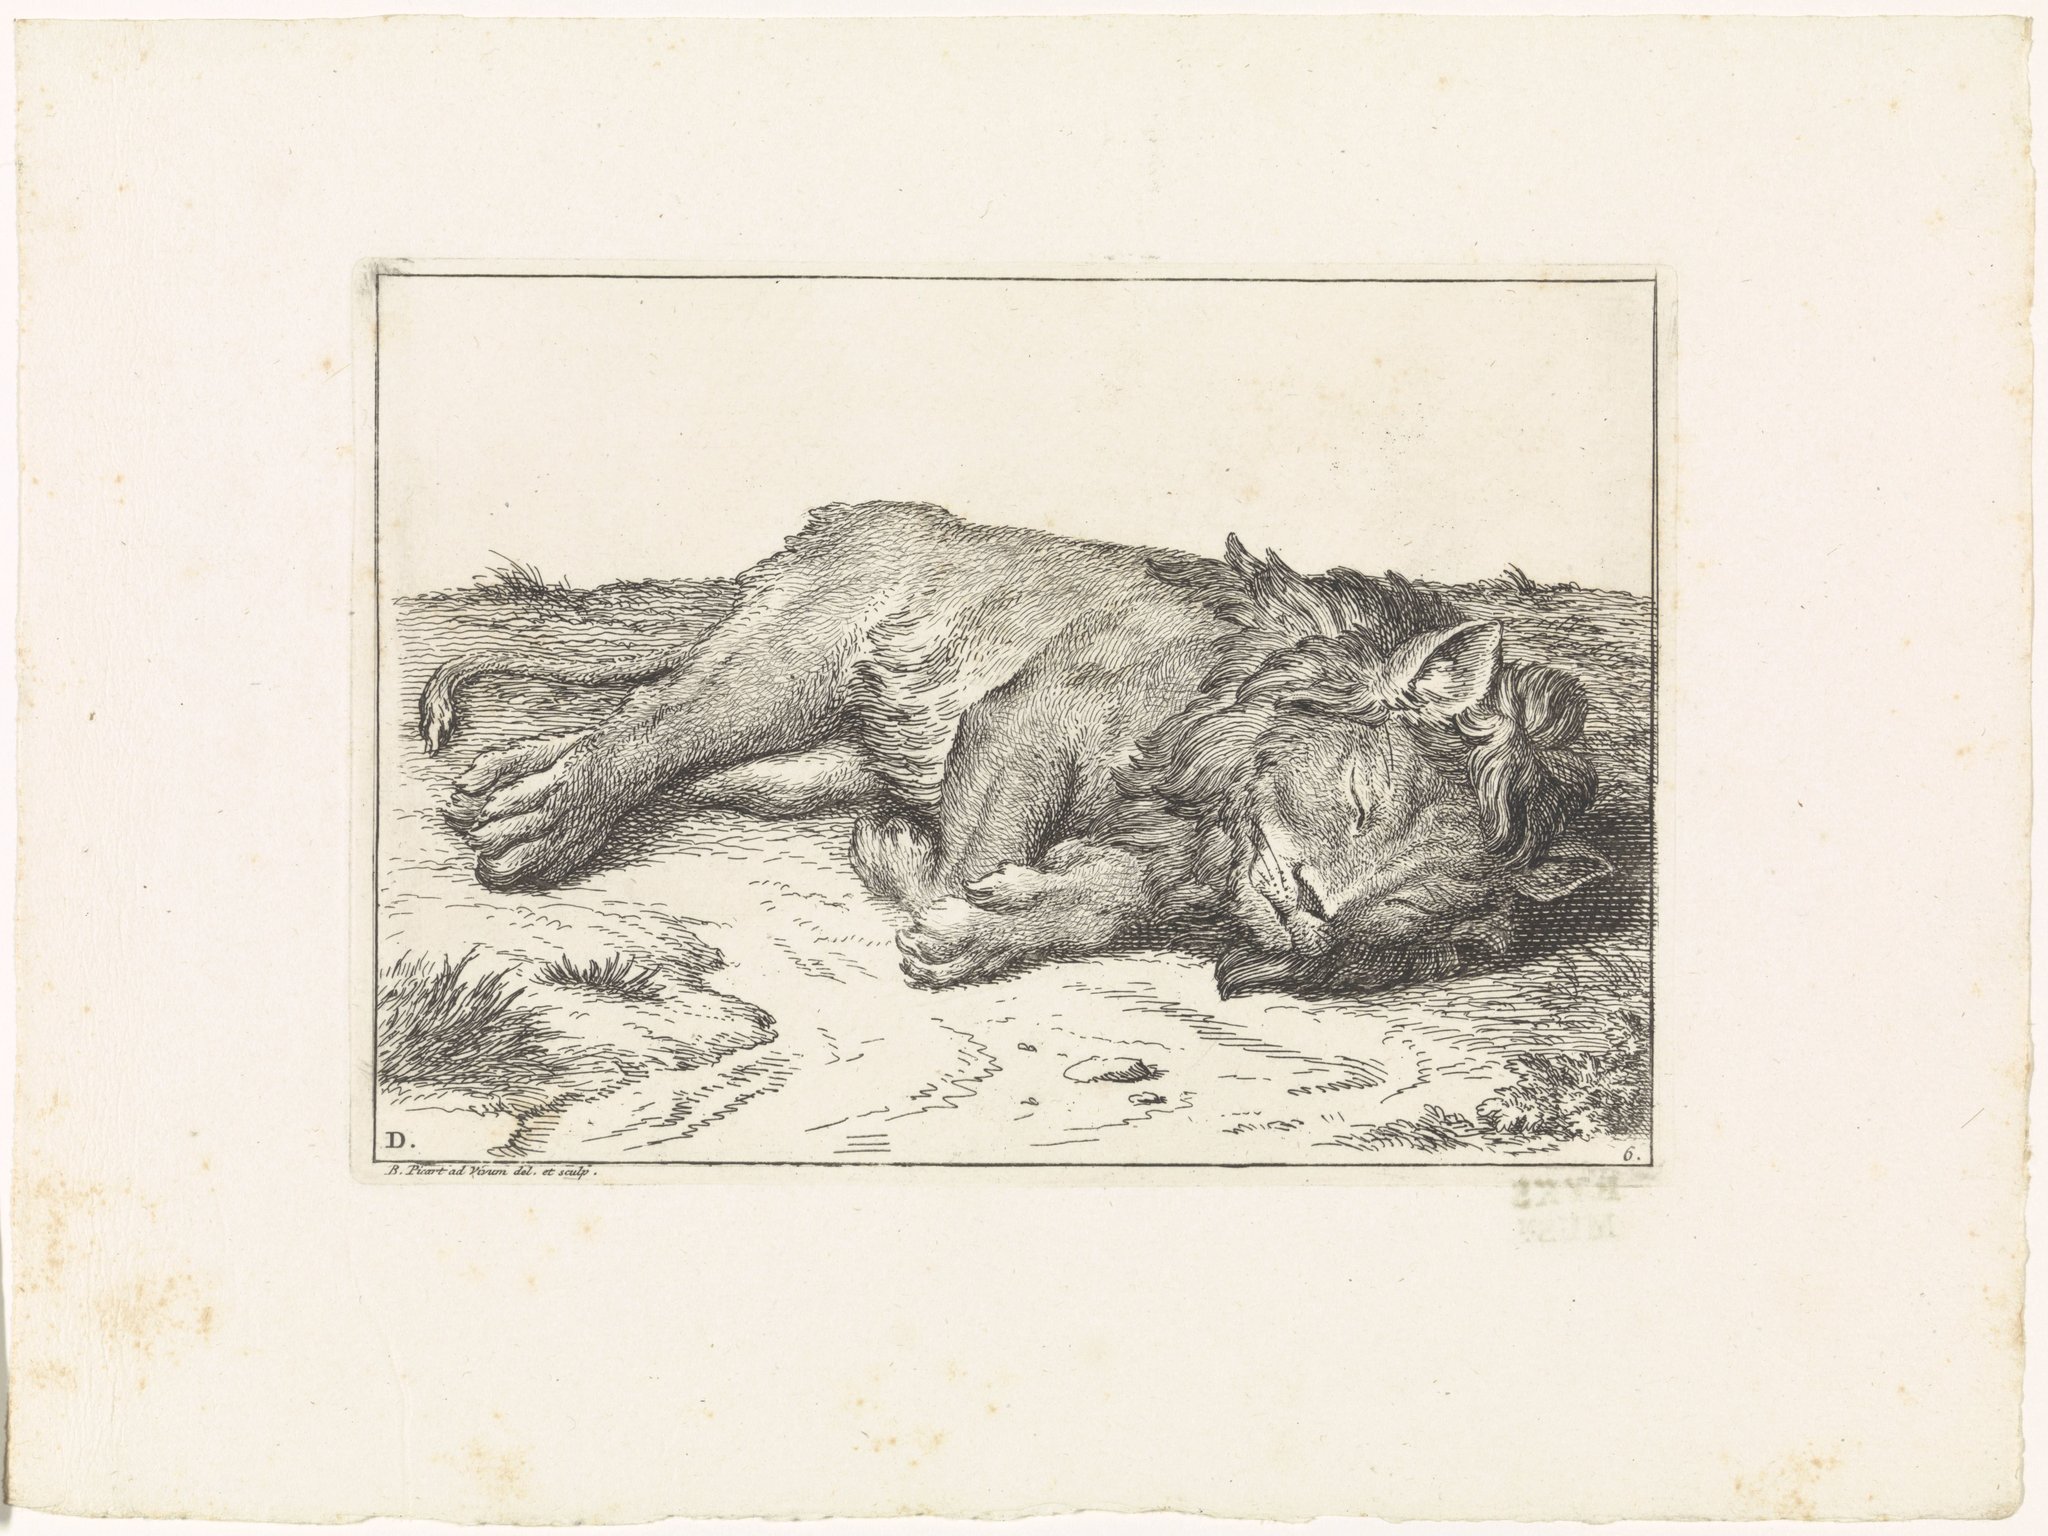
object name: print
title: Receuïl de Lions (...)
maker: bernard picart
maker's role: draughtsman, print maker, publisher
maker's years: 1673-1733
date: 1729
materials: paper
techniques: etching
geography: amsterdam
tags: beasts of prey, predatory animals: lion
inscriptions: collector's mark: Lugt 2165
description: Prent ook als illustratie gebruikt in: Recueil de lions, dessinez d'après nature par divers maitres. Amsterdam: Bernard Picart, 1729.